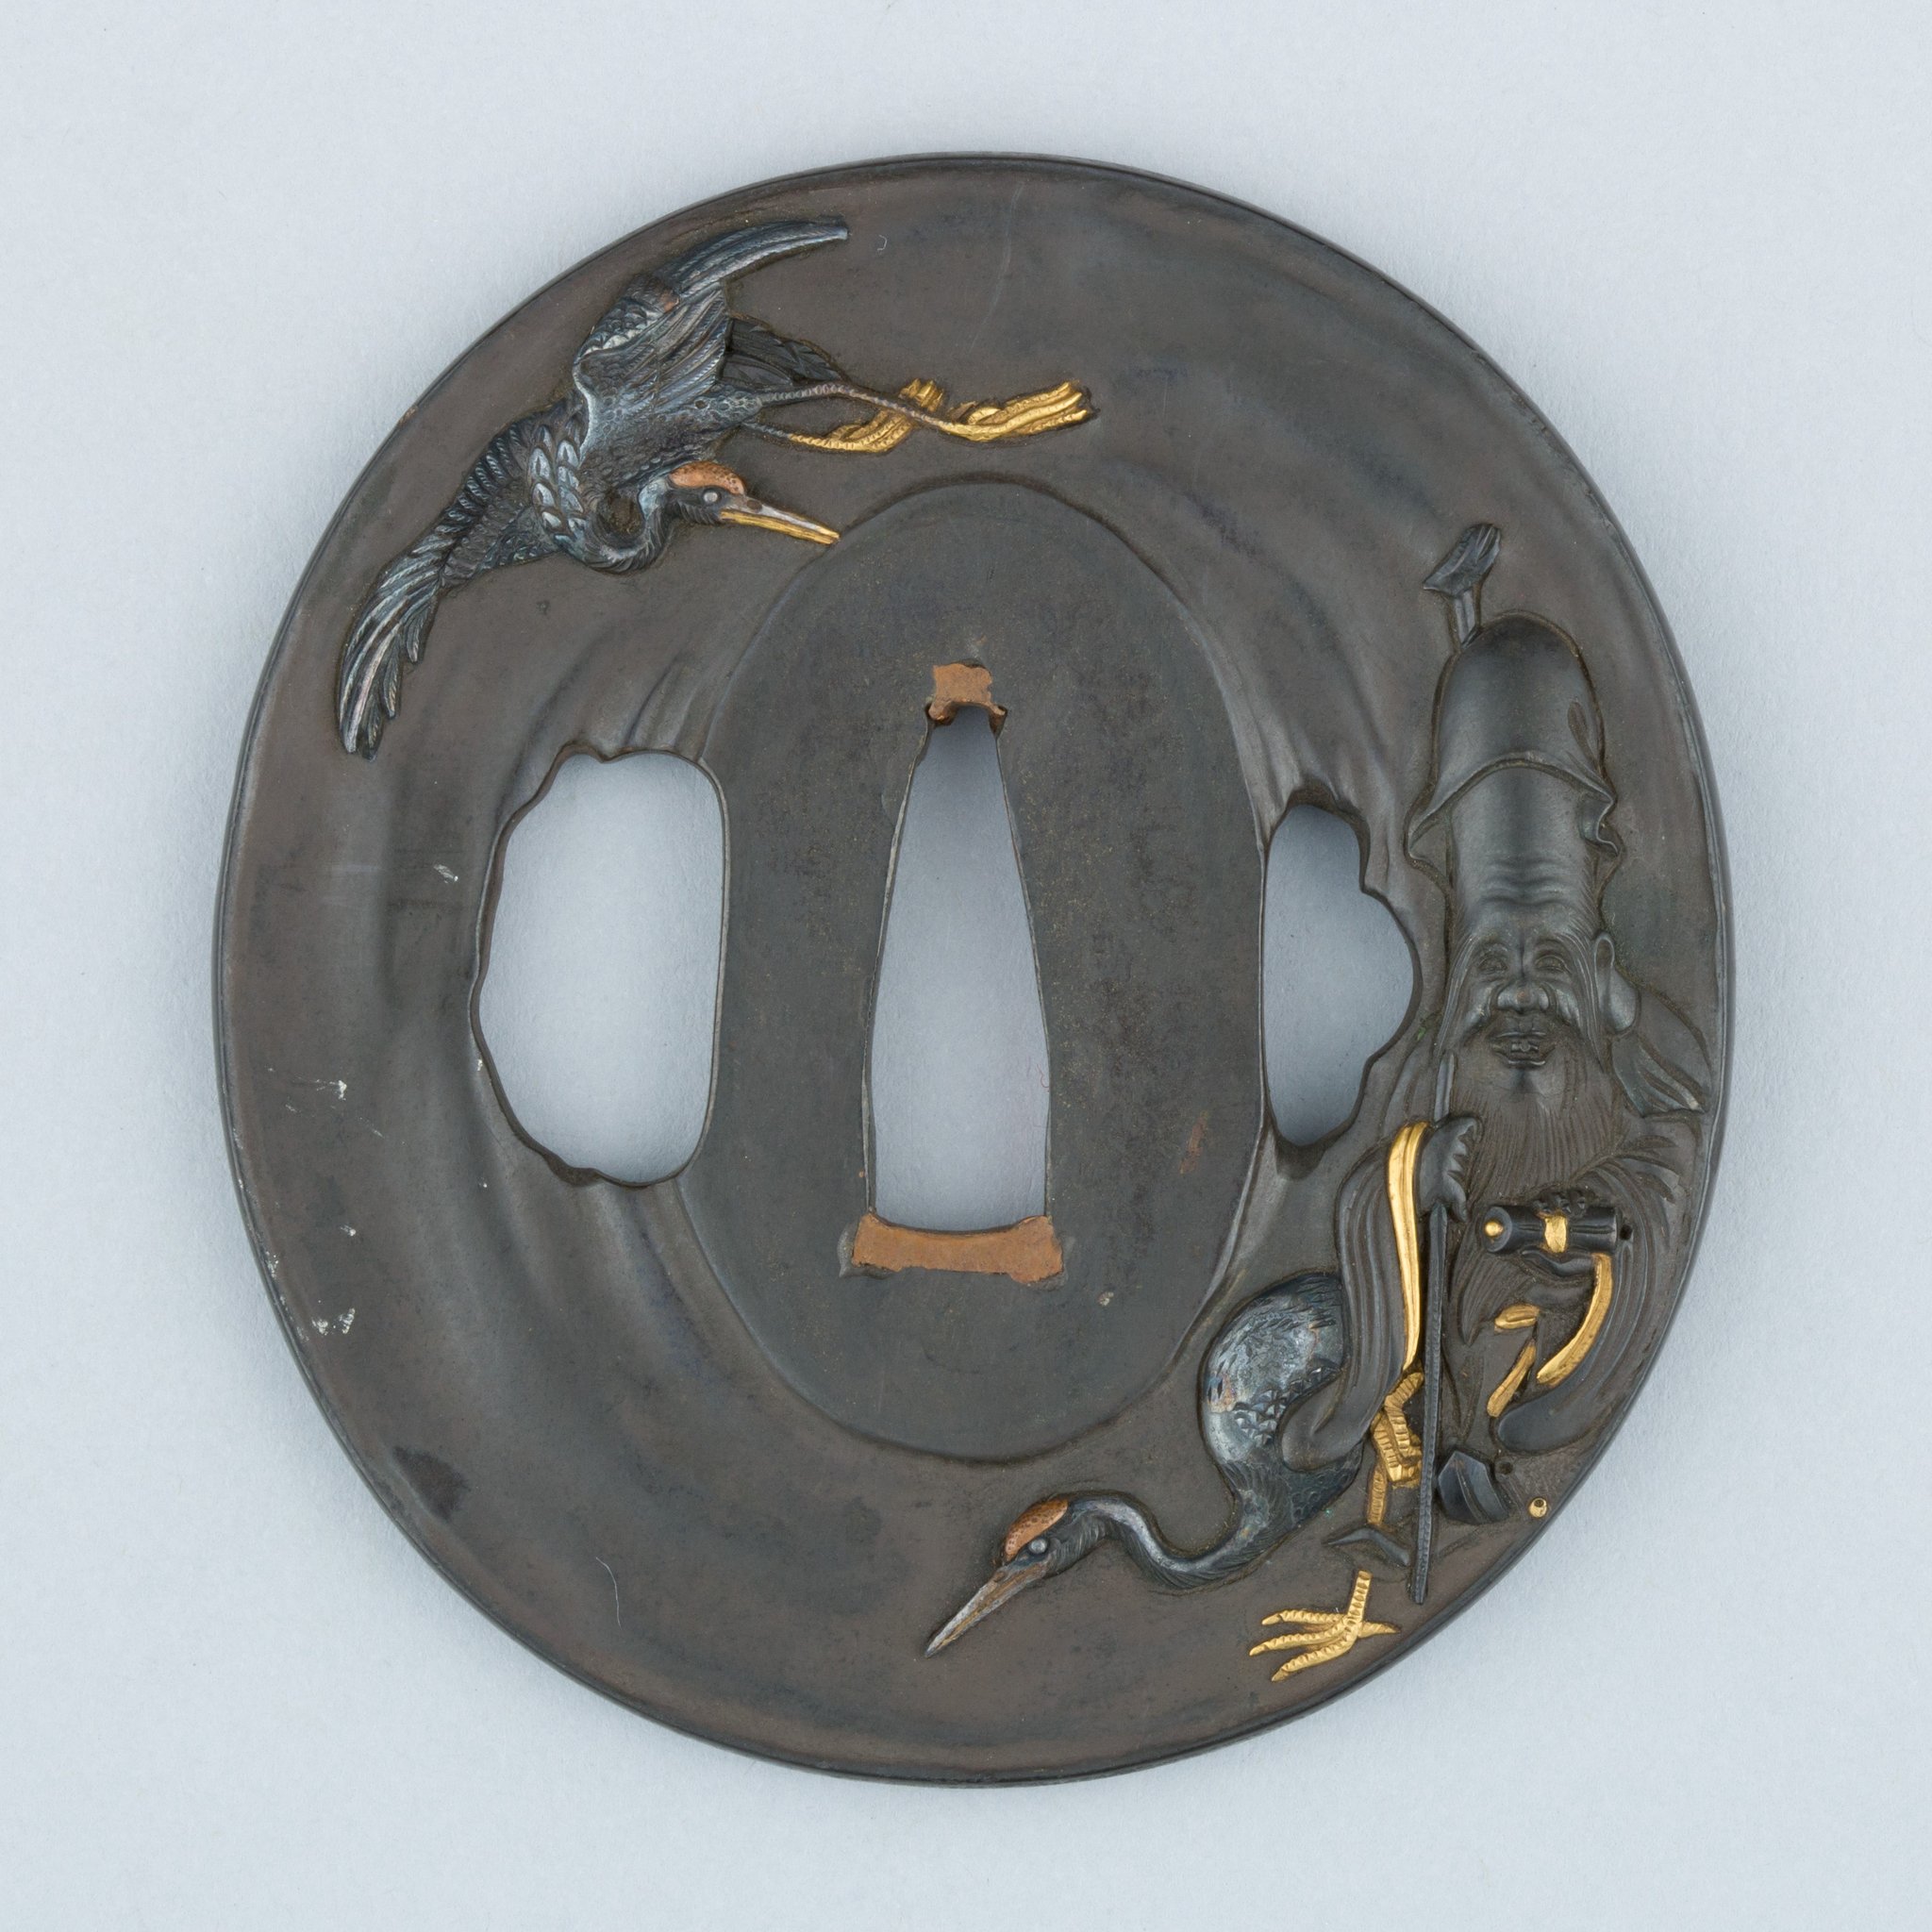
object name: sword guard tsuba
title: Sword Guard (Tsuba)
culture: japanese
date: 1615-1868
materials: copper, silver alloy, gold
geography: japan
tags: cranes,men